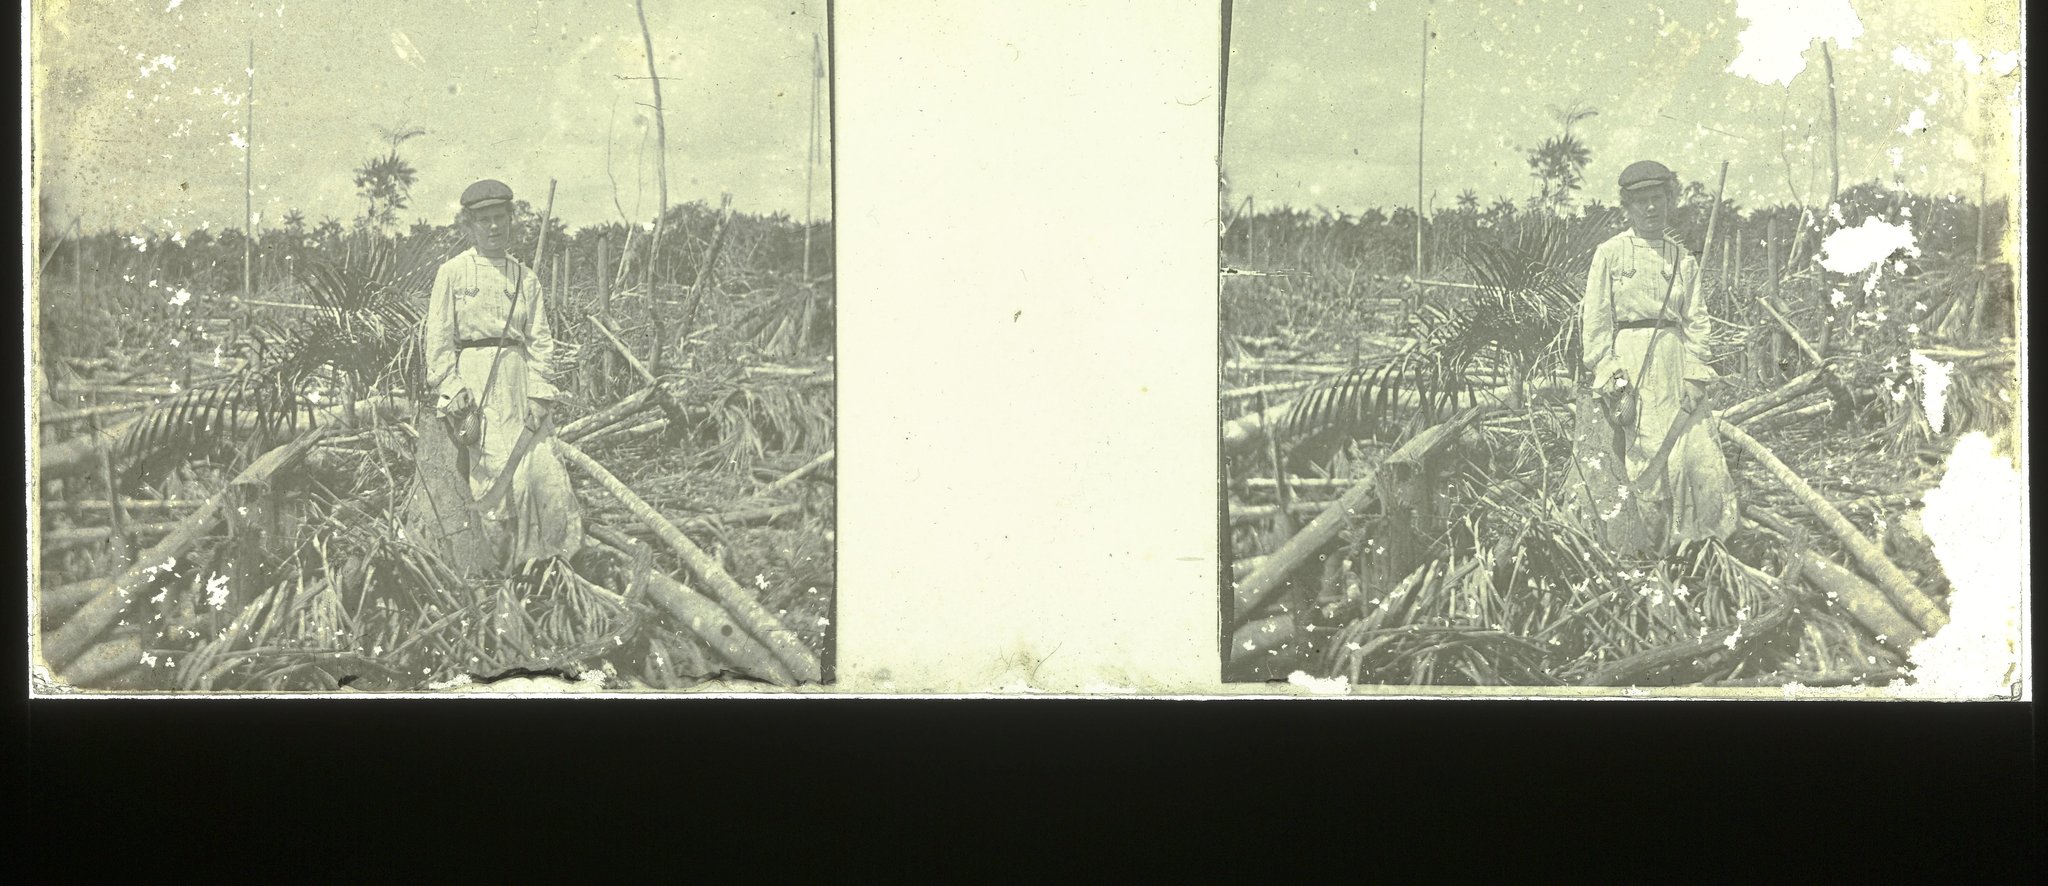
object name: stereograph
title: Plantage Accaribo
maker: theodoor brouwers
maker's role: amateurfotograaf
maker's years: 1874-1932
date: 1913-1930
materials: glass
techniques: photography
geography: suriname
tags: amsterdam, theodoor brouwers, plantation, suriname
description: In de periode 1911-1932 woonde op plantage Accaribo in Suriname de familie Brouwers van wie de foto's afkomstig zijn. Rond 1910 vond Theodoor Brouwers werk op plantage Accaribo. In 1929 werd hij eigenaar van de plantage. Op Accaribo werden in zijn tijd bananen geproduceerd en wat koffie.